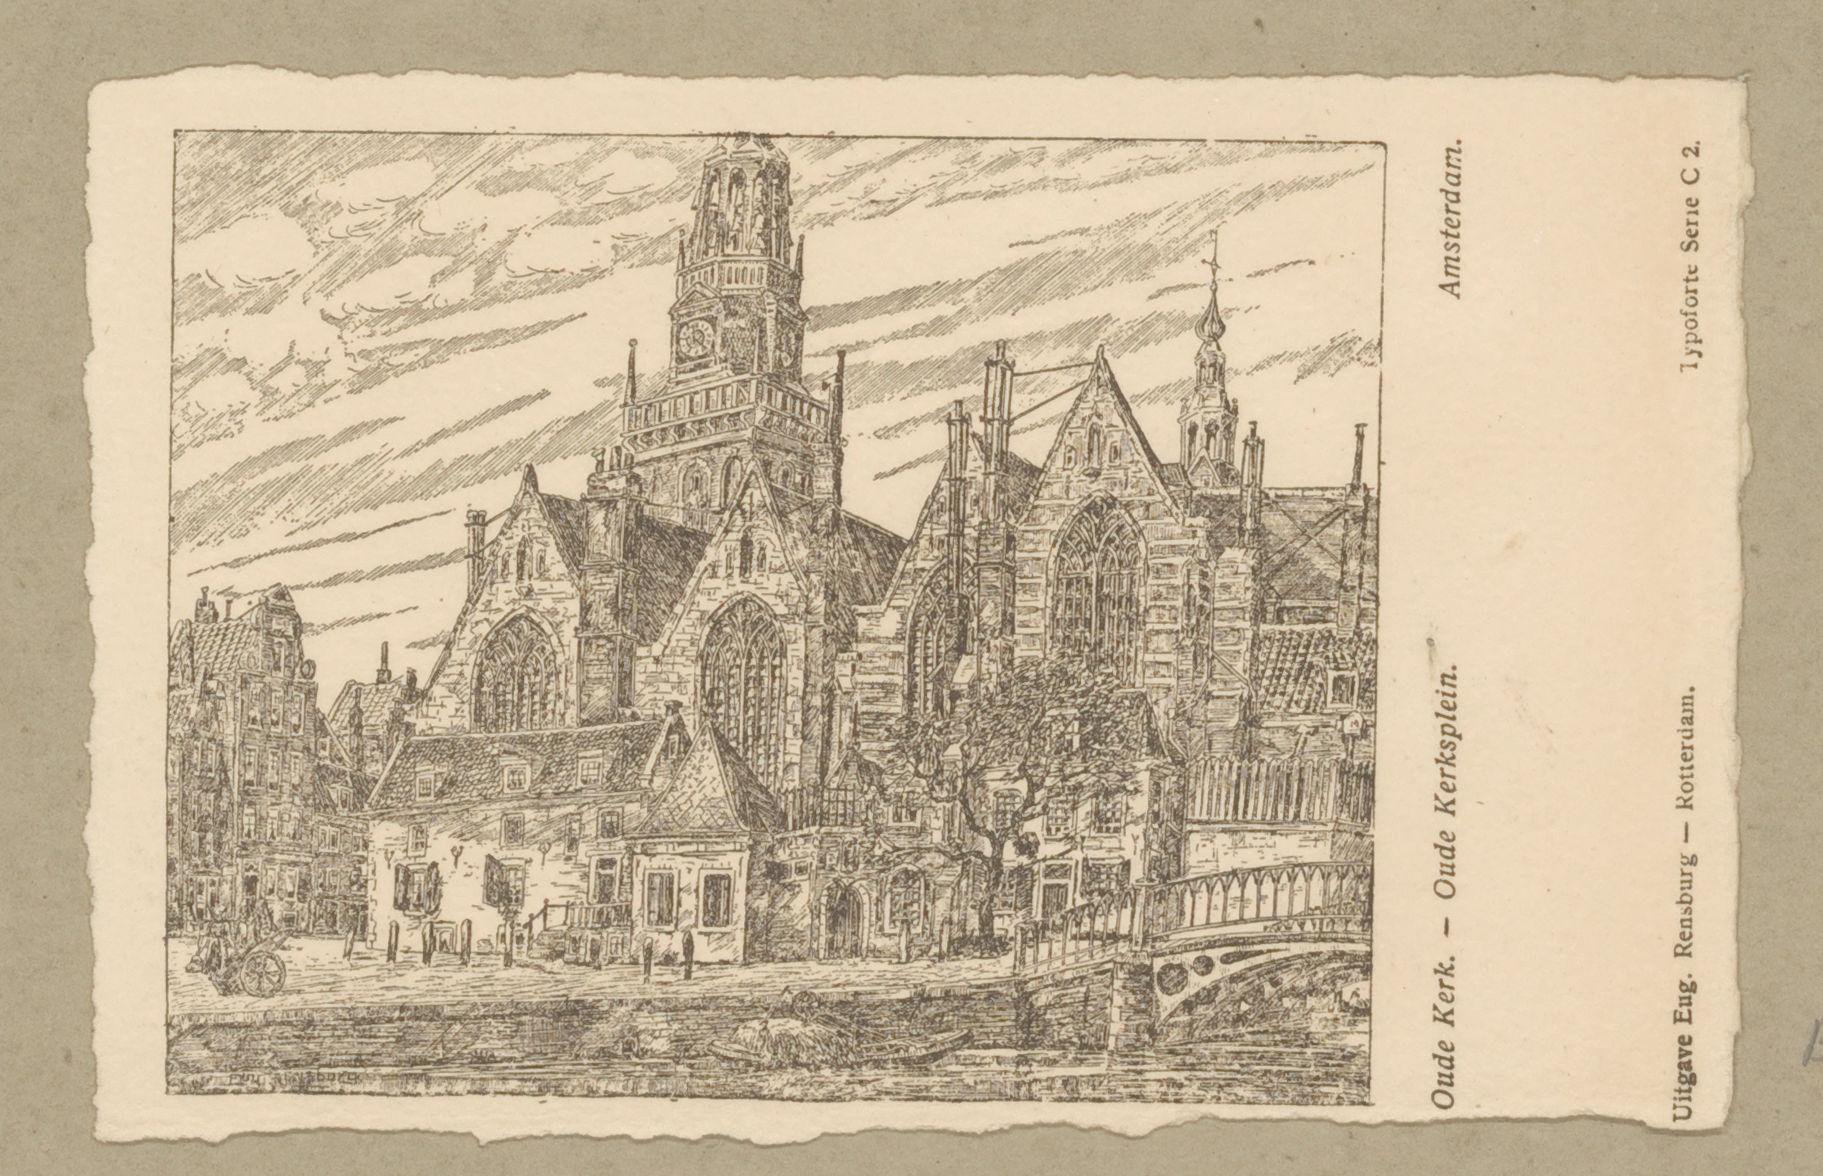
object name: photomechanical print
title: Oude Kerk. - Oude Kerksplein. Amsterdam.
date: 1882-1956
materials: cardboard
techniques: letterpress printing, line block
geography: rotterdam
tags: church (exterior), bridge in city across river, canal, etc.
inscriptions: collector's mark: ‘31.93 A/B’ Lugt 1641b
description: Onderwerpsrubriek binnen de Atlas Amsterdam: Kerkwezen: Hervormde Gemeente: Oude Kerk van buiten.